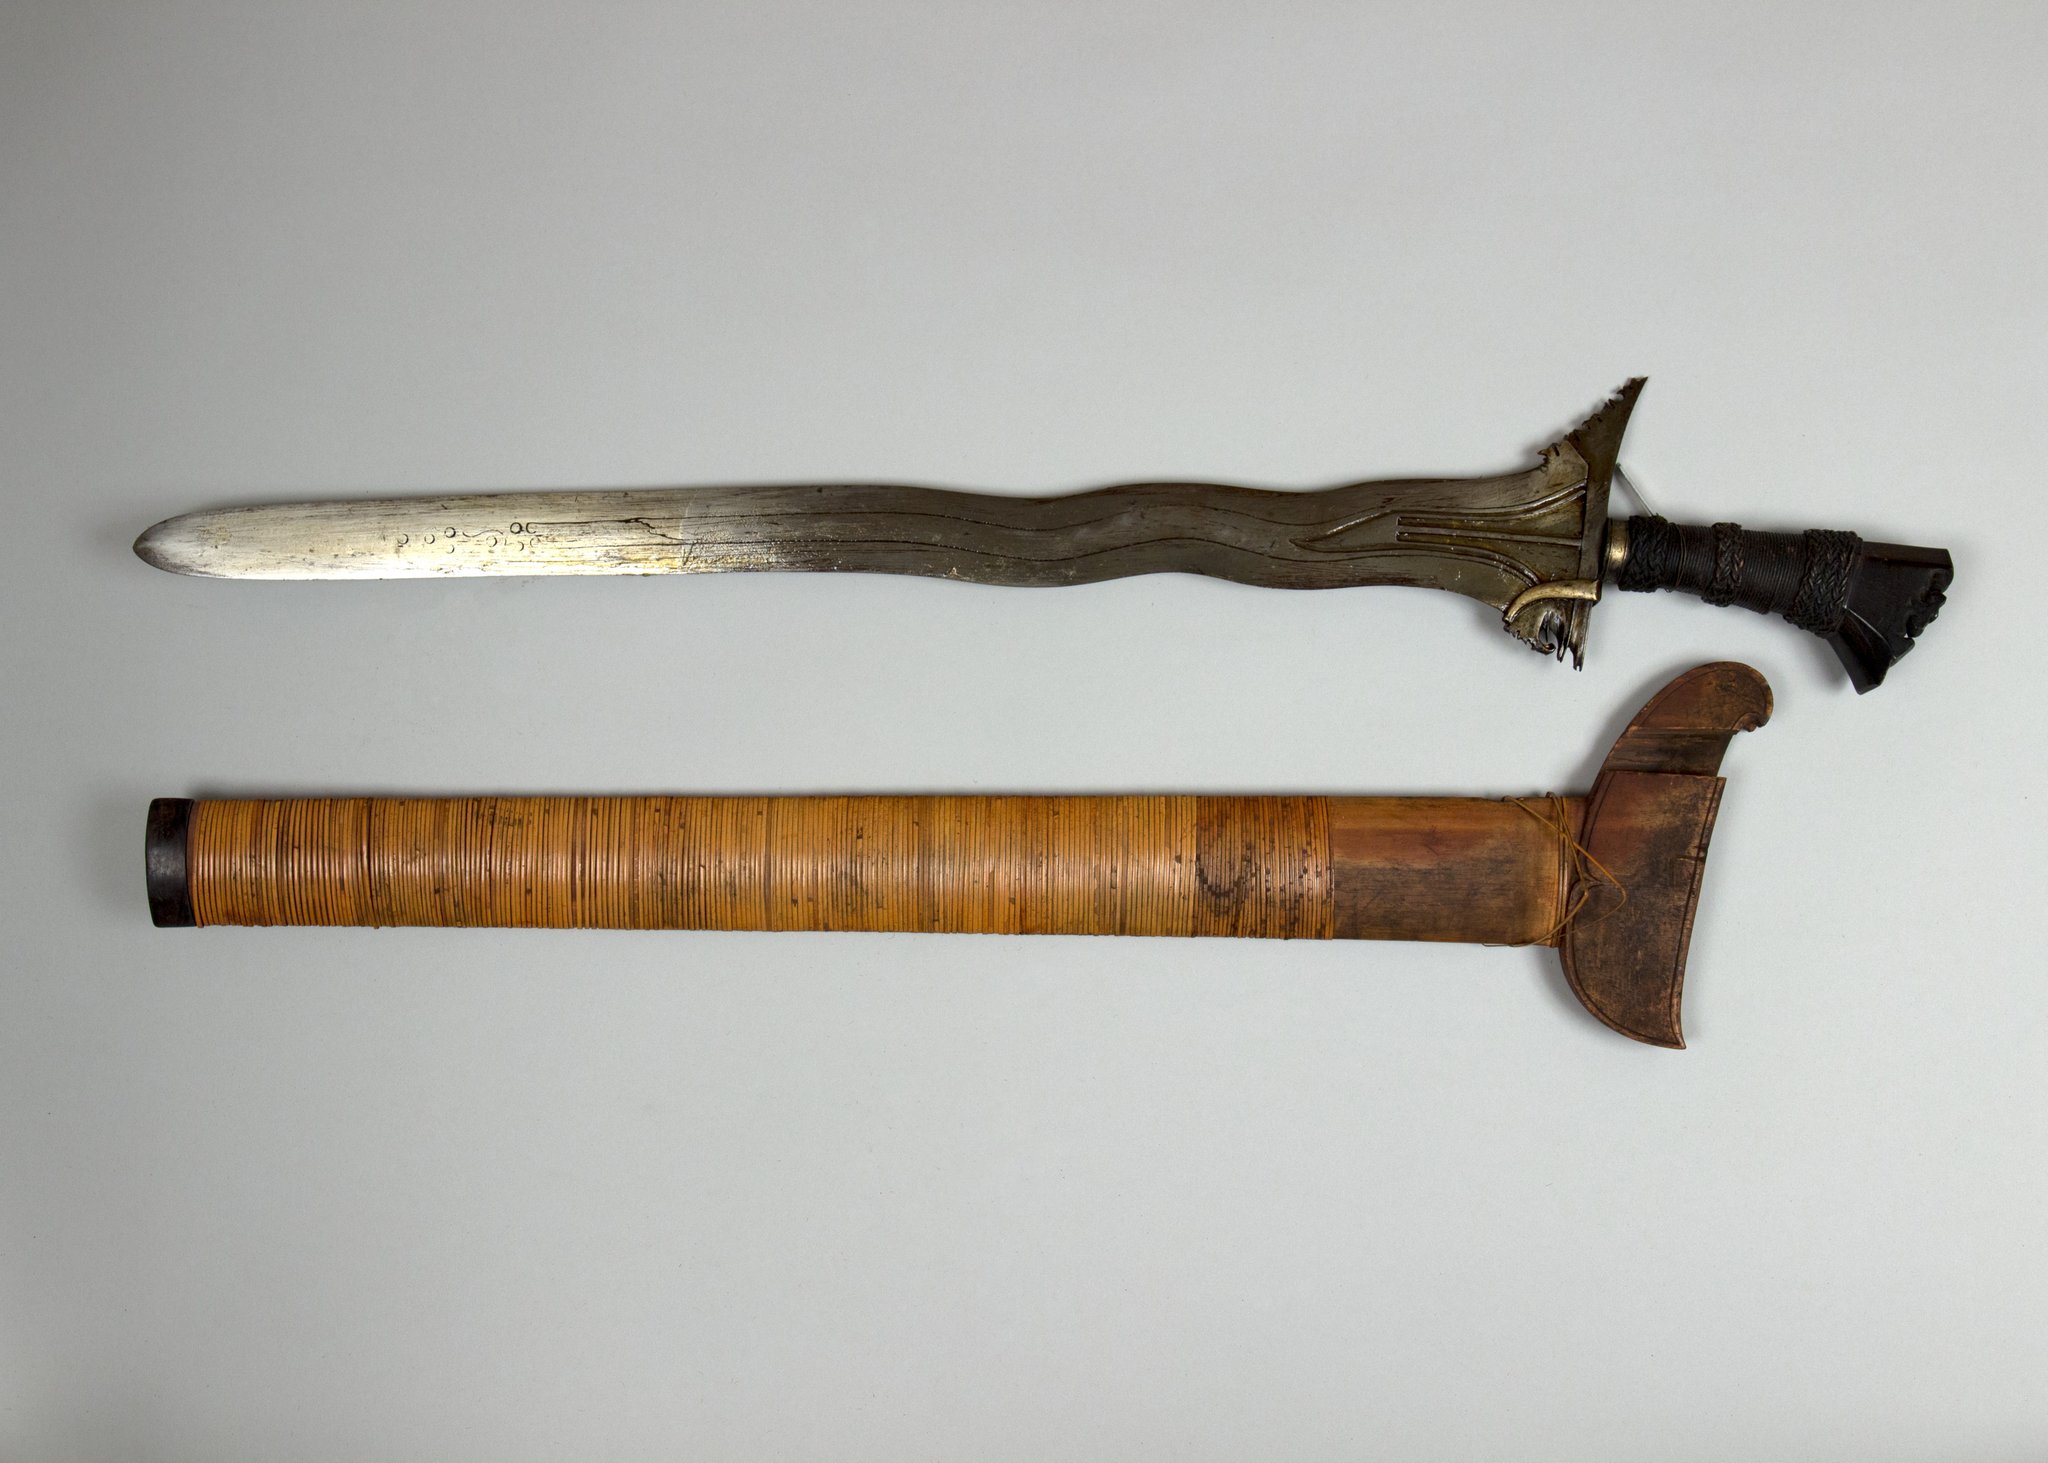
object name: kris with sheath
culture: philippine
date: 1701-1900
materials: cord, horn, steel, wood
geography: philippines